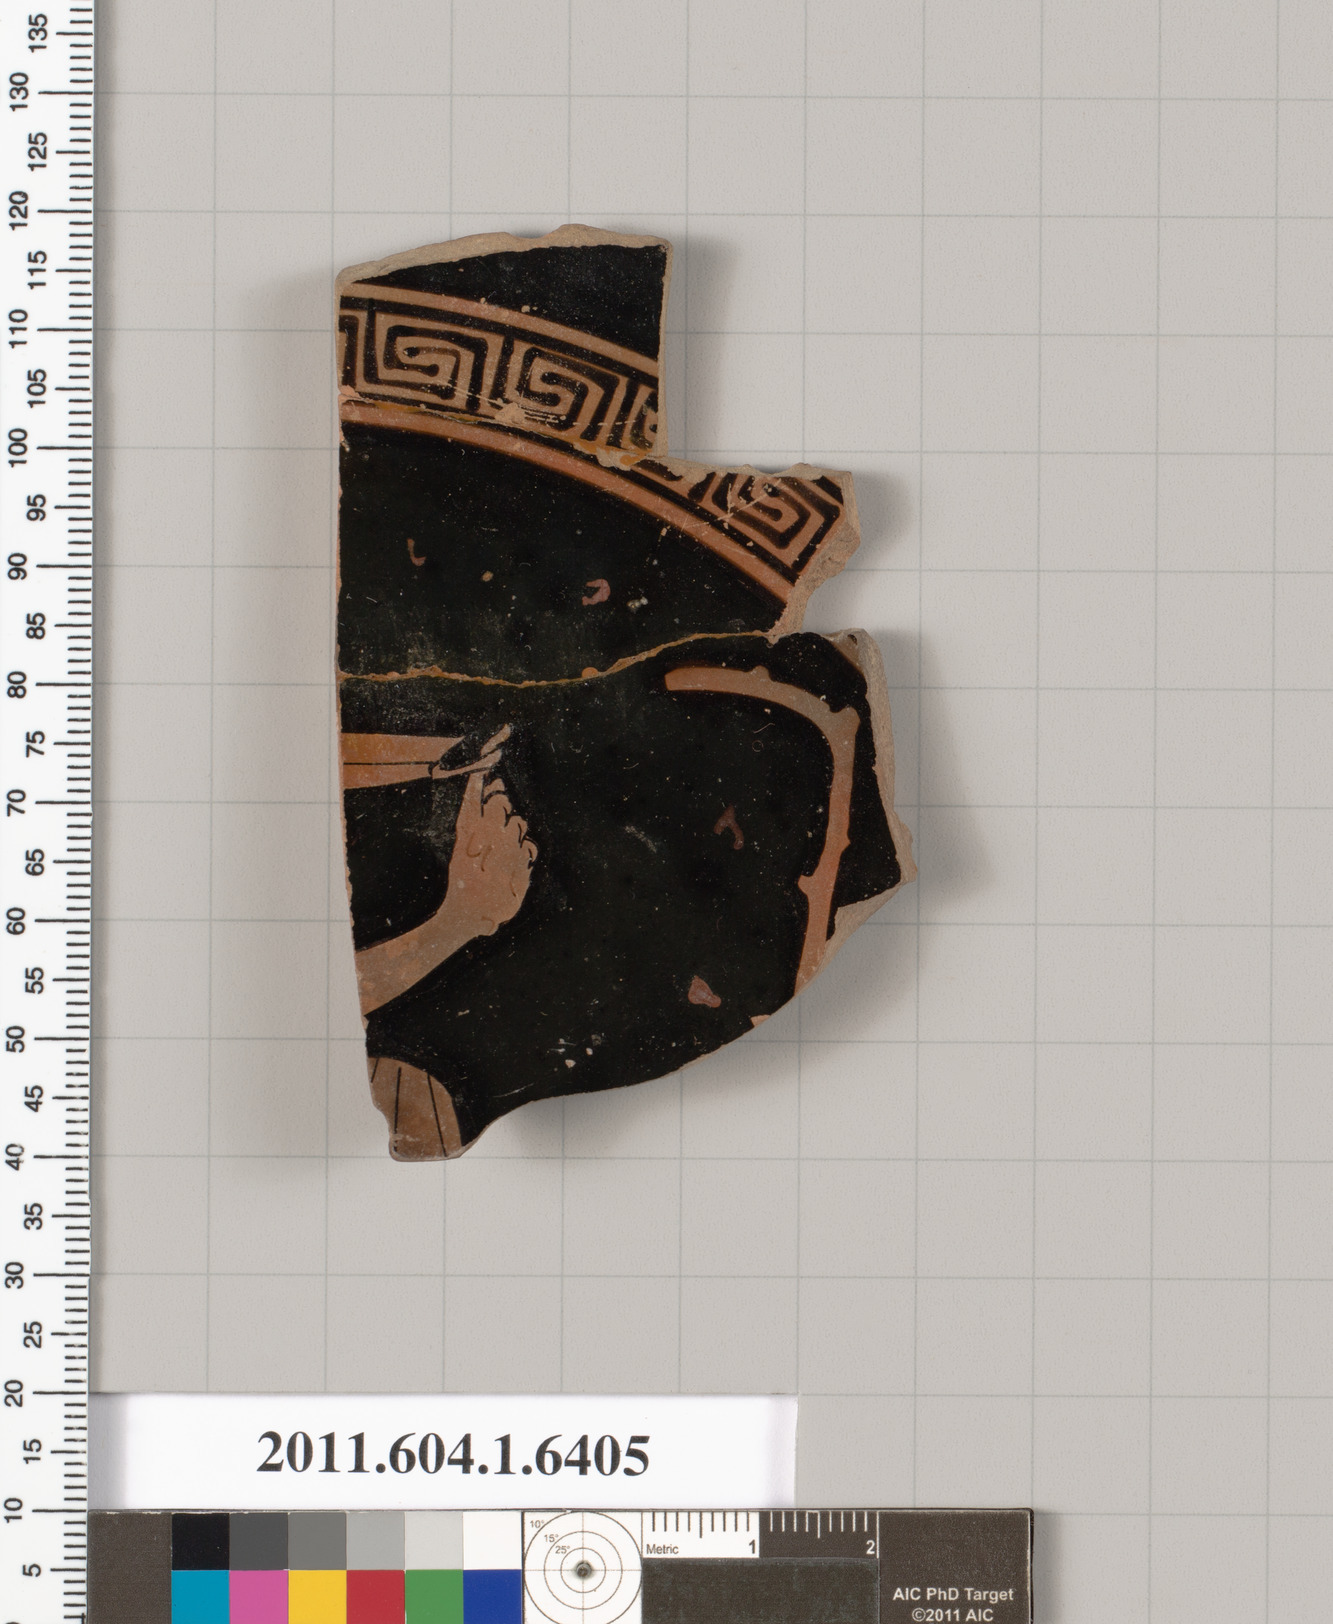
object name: kylix fragment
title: Terracotta fragment of a kylix (drinking cup)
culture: greek, attic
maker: cage painter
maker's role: artist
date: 490-480 BCE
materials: terracotta